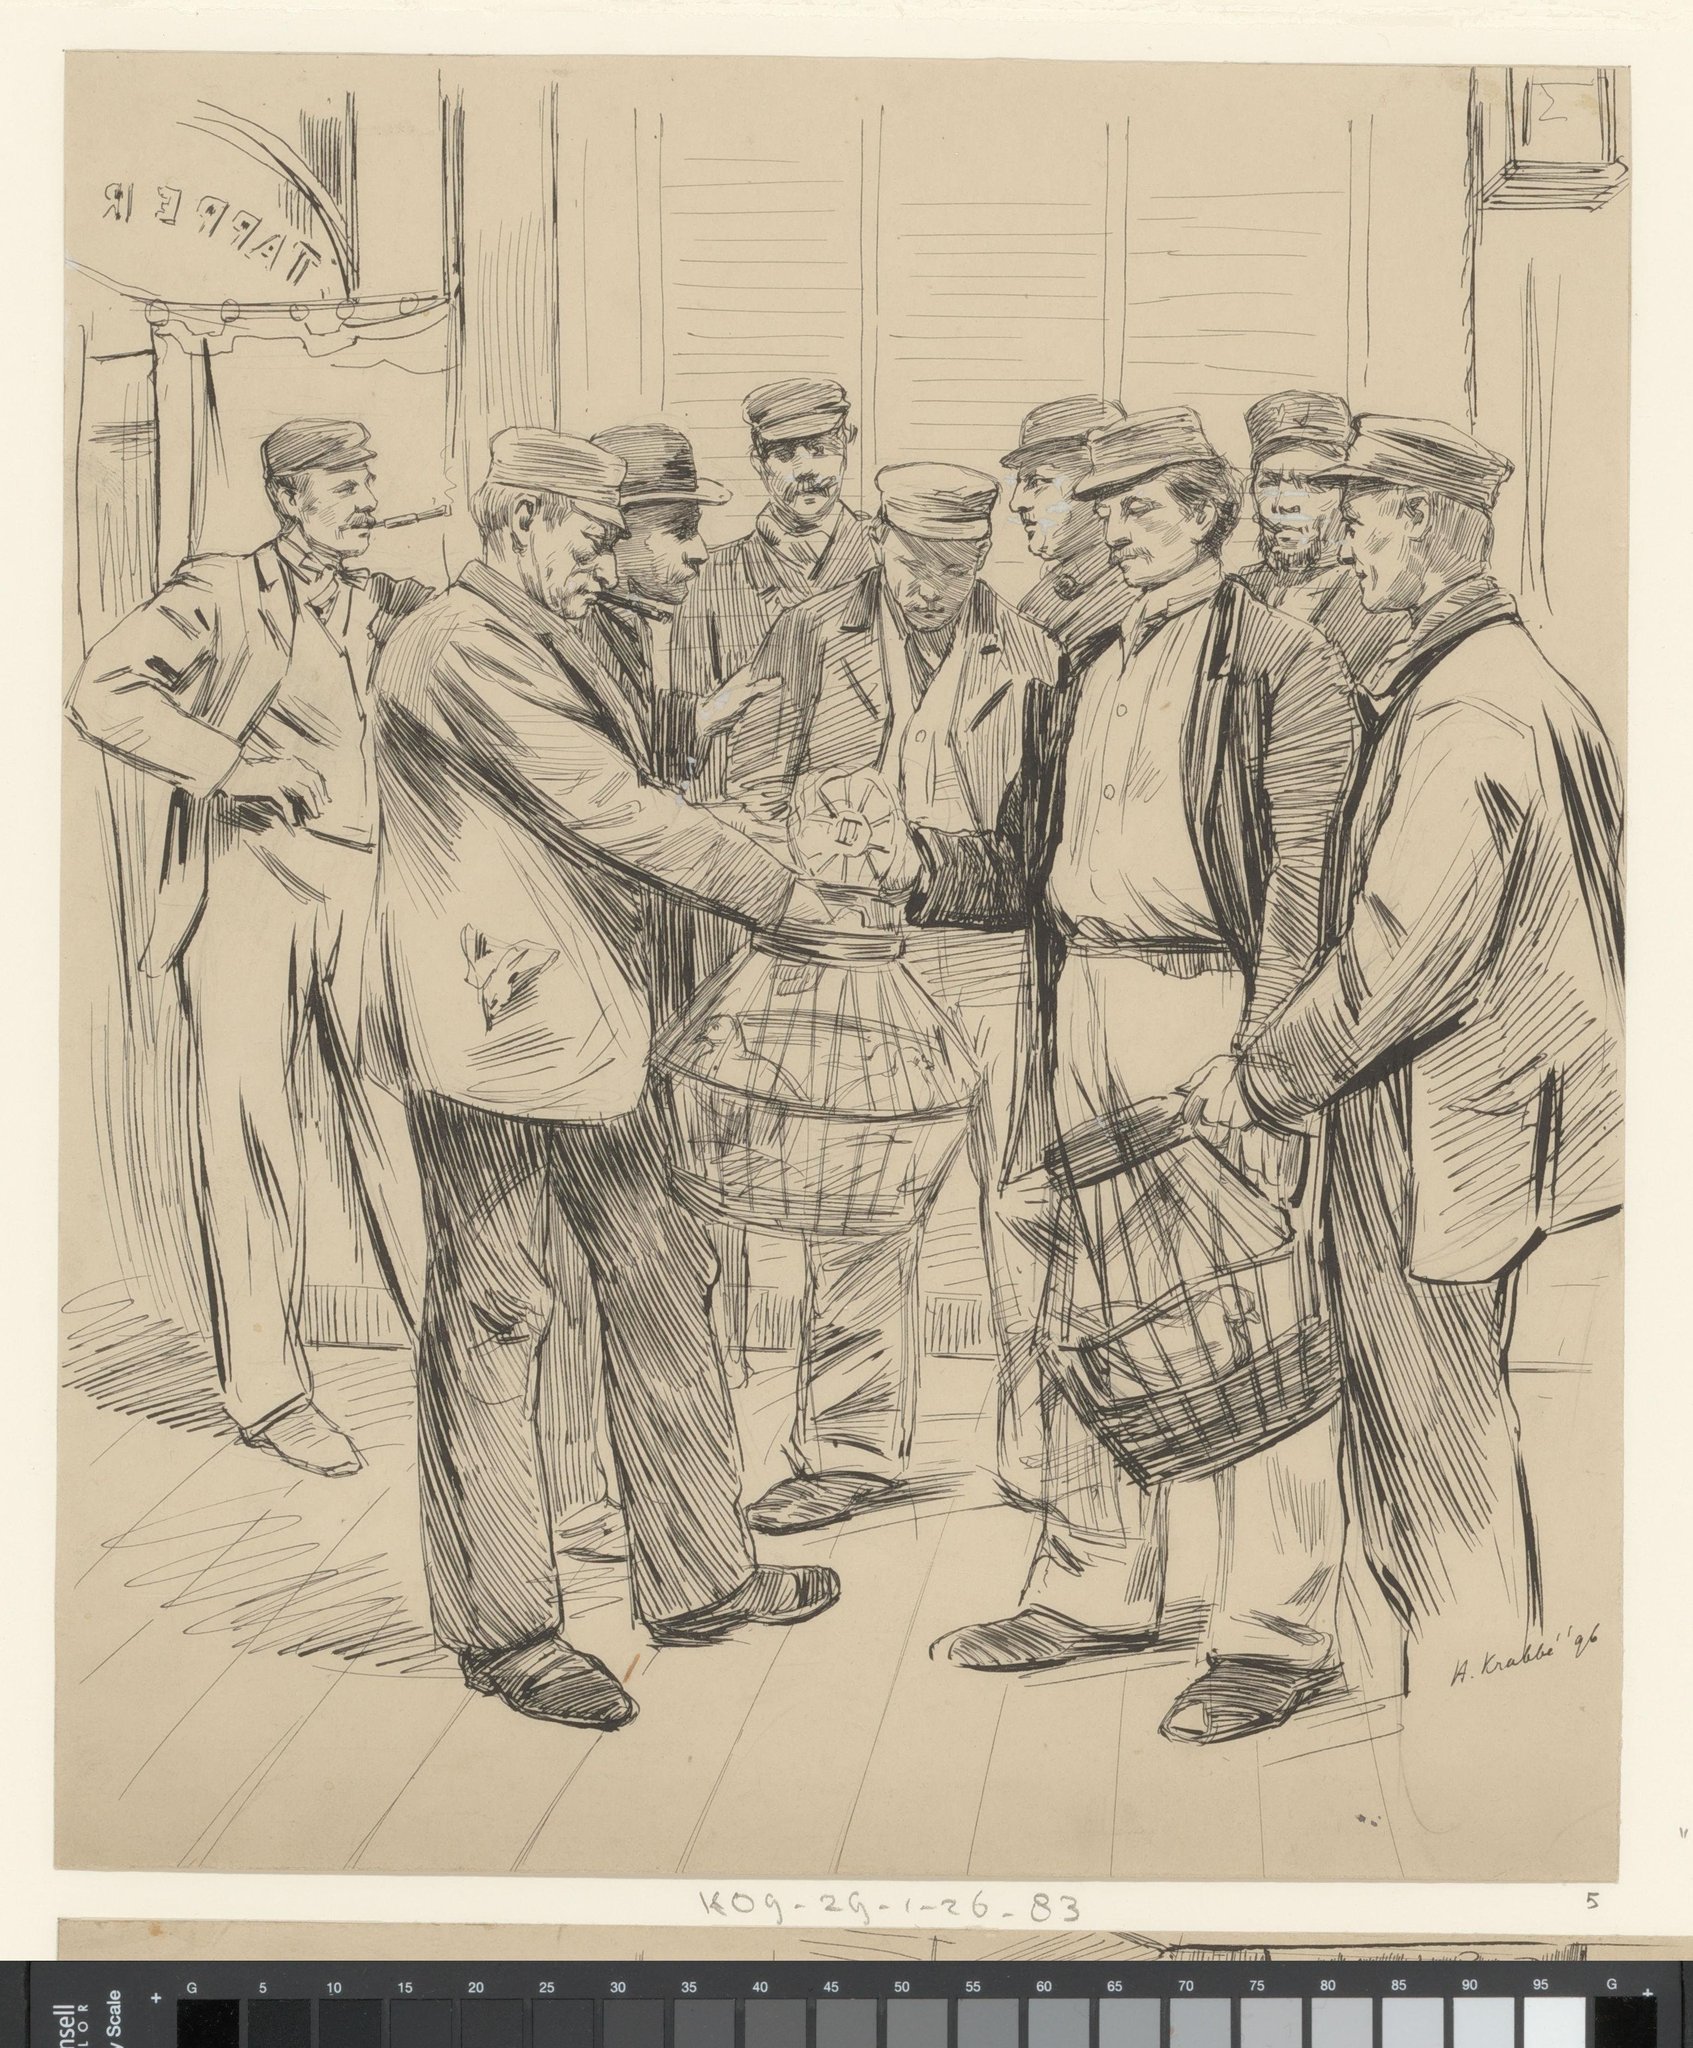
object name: drawing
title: De duivenbeurs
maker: heinrich m. krabbé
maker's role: draughtsman, print maker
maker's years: 1868-1931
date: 1896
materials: paint, ink, paper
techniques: brush, pen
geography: netherlands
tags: pigeons (racing), inn, coffee-house, public house, etc., container made of plant material other than wood: basket, doves, pigeons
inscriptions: collector's mark, collector's mark: Lugt 1641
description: Groep duivenhandelaren staat bij elkaar, twee hebben duiven in manden bij zich. In of voor het café genaamd 'De Duivenbeurs'. Duivensport in de Amsterdamse Jordaan. Onderwerpsrubrieken binnen de Atlas Zeden en Gewoonten: Spel en Vermaak; Duiven in de Jordaan.